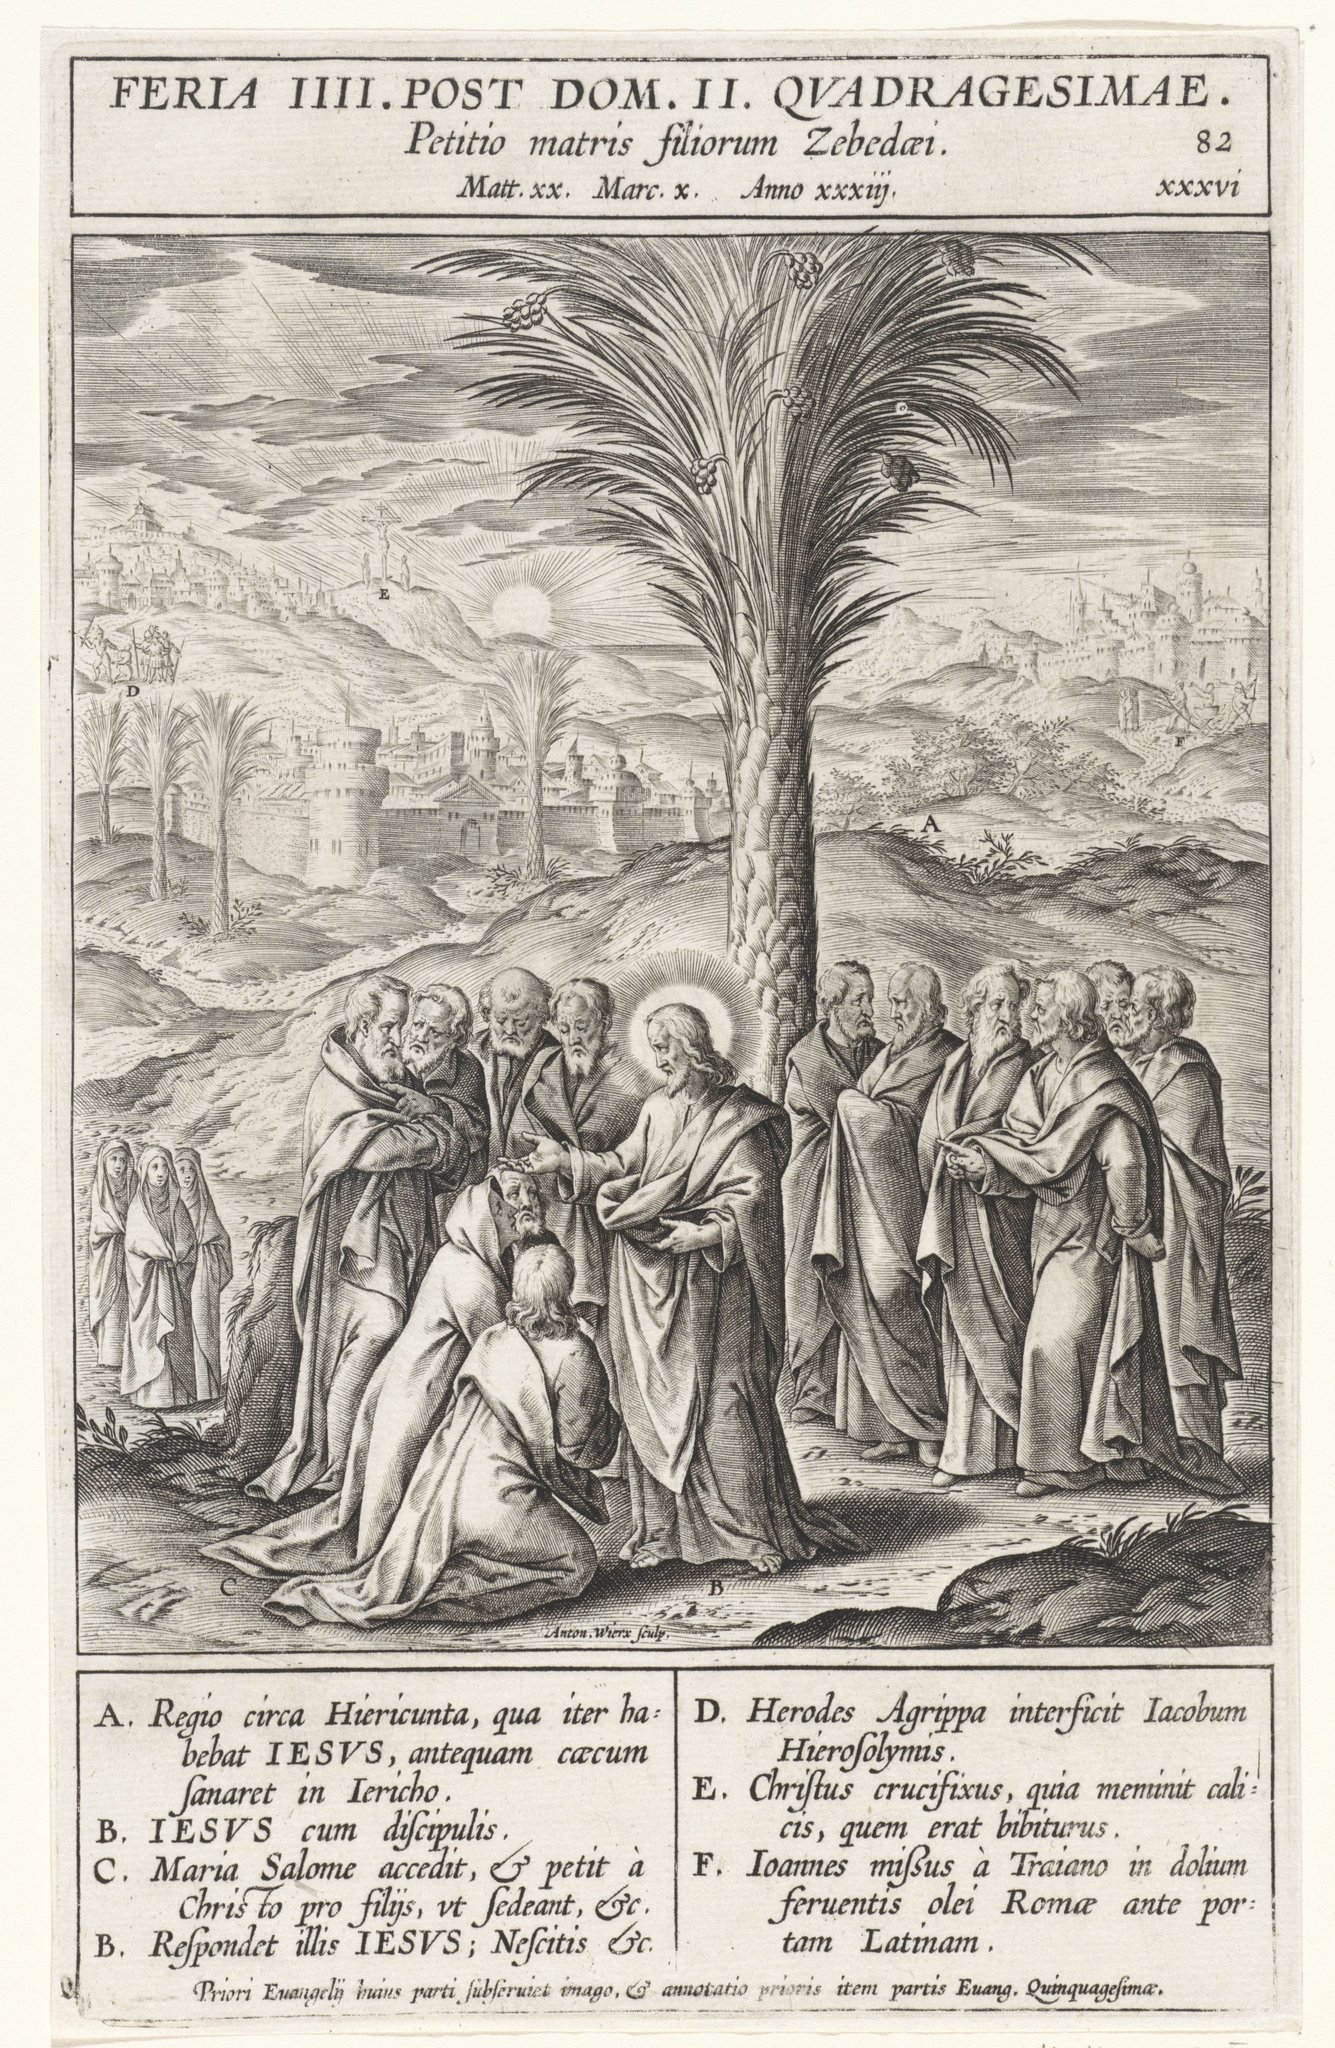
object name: print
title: Christus en de moeder van de zonen van Zebedeüs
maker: antonie wierix (ii)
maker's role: draughtsman, print maker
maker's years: 1555-1604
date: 1593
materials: paper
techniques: engraving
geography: antwerp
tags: request of the mother of the sons of zebedee (matthew 20:20-21)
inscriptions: collector's mark: Lugt 2165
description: De moeder van de zonen van Zebedeüs knielt met haar zonen voor Christus. De vrouw vraagt Christus of haar zonen in zijn koninkrijk naast hem mogen zitten. De leerlingen van Christus kijken toe. Bij verschillende elementen uit de voorstelling staan letters die corresponderen met de legenda in de marge.